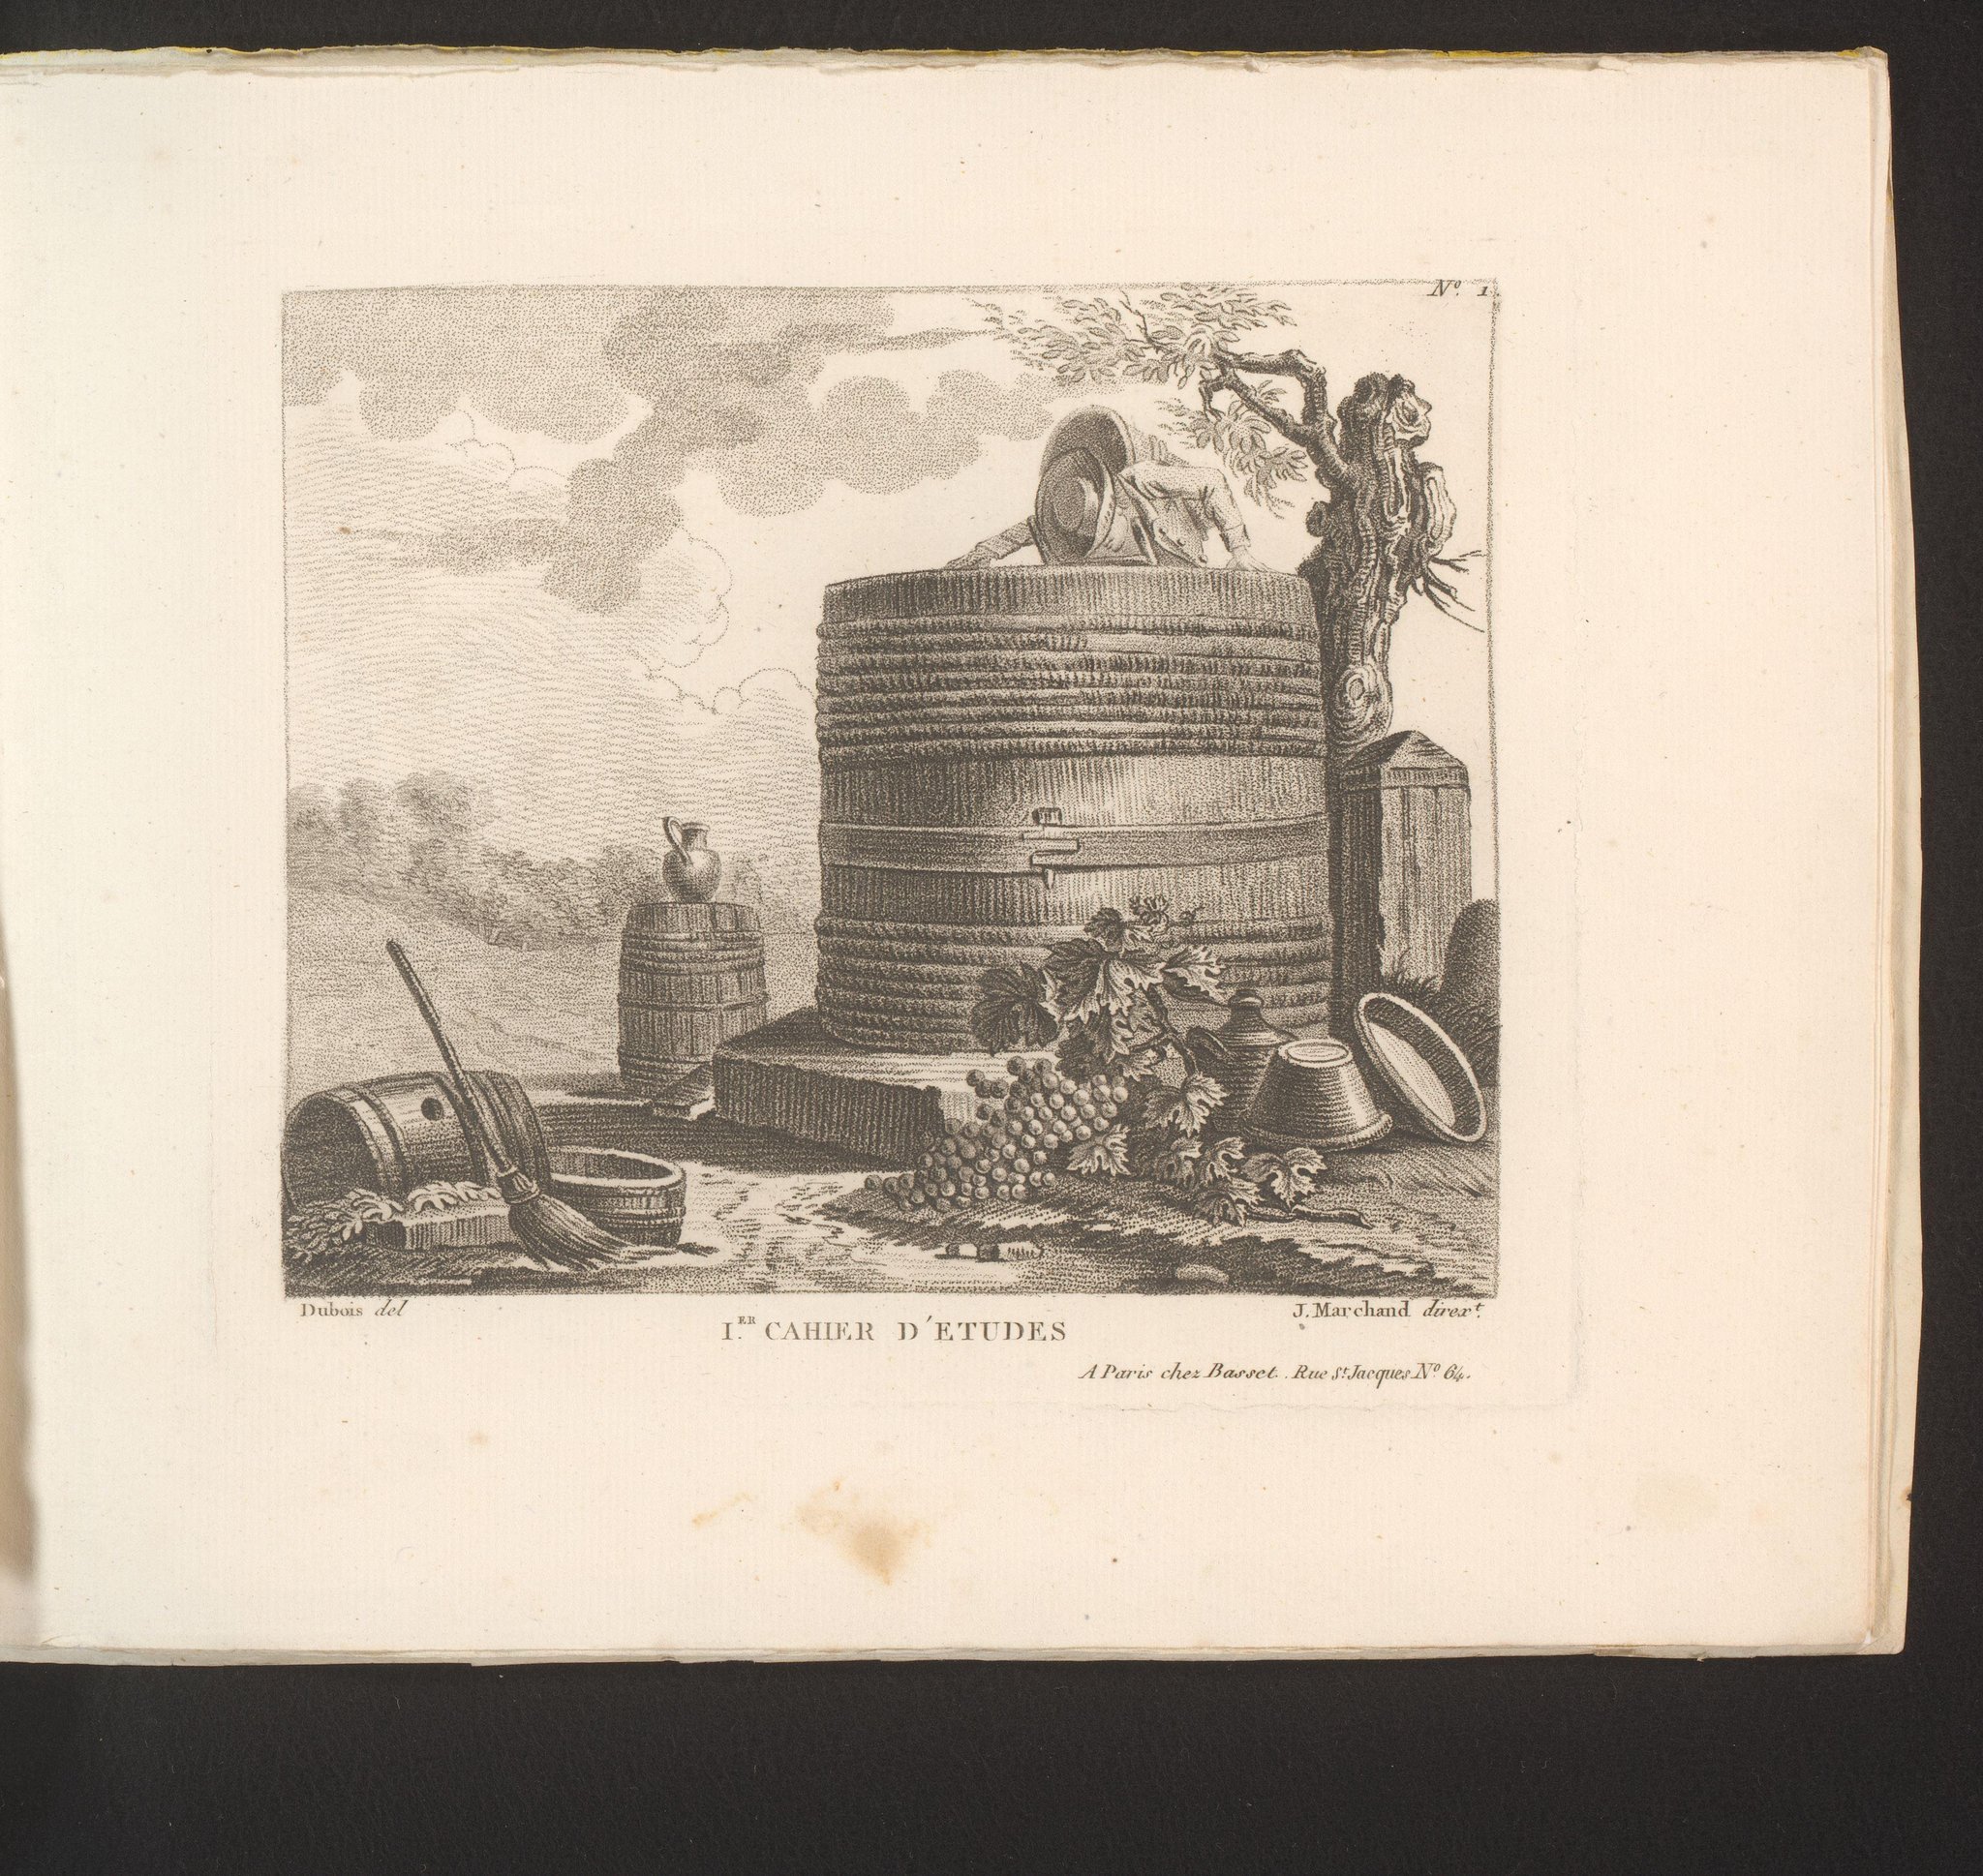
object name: print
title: I.er cahier d'etudes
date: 1800-1825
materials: paper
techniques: printmaking, engraving, etching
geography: paris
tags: wooden container: barrel, cask, bucket, wine-press, bunch of grapes, viticulture, wine-growing; vintage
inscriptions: collector's mark: Lugt 2228, collector's mark: Lugt 2760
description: Wijnpers, druiventrossen en ander landbouwgereedschap. Deze prent maakt deel uit van een album.